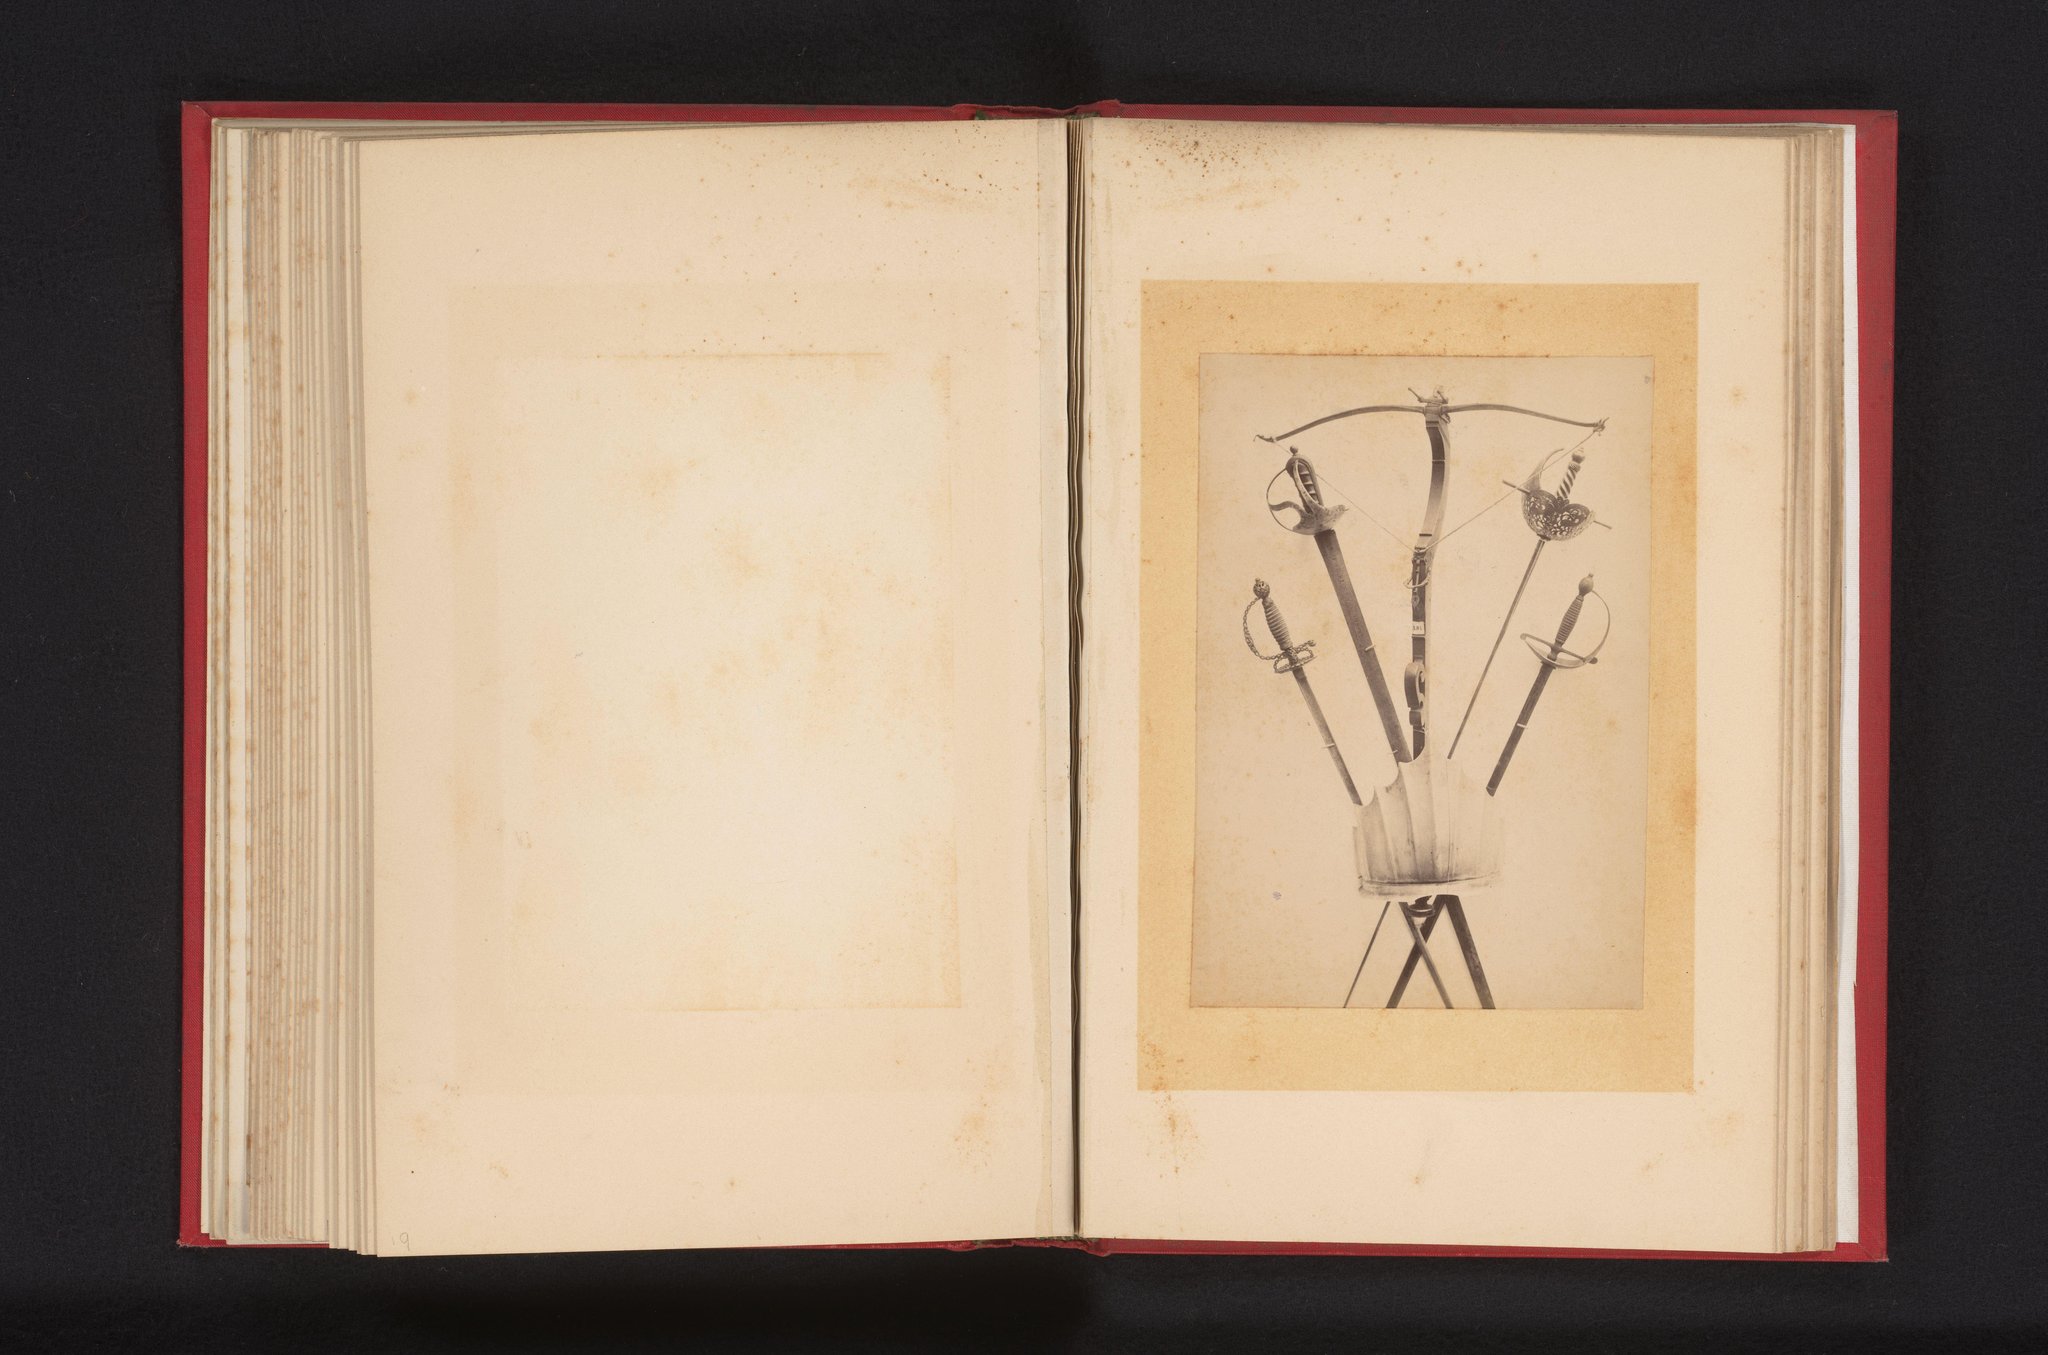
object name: page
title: Kruisboog en sabels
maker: Anonymous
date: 1873-1878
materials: photographic support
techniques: albumen print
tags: hacking and thrusting weapons (with name), archer's weapons: crossbow